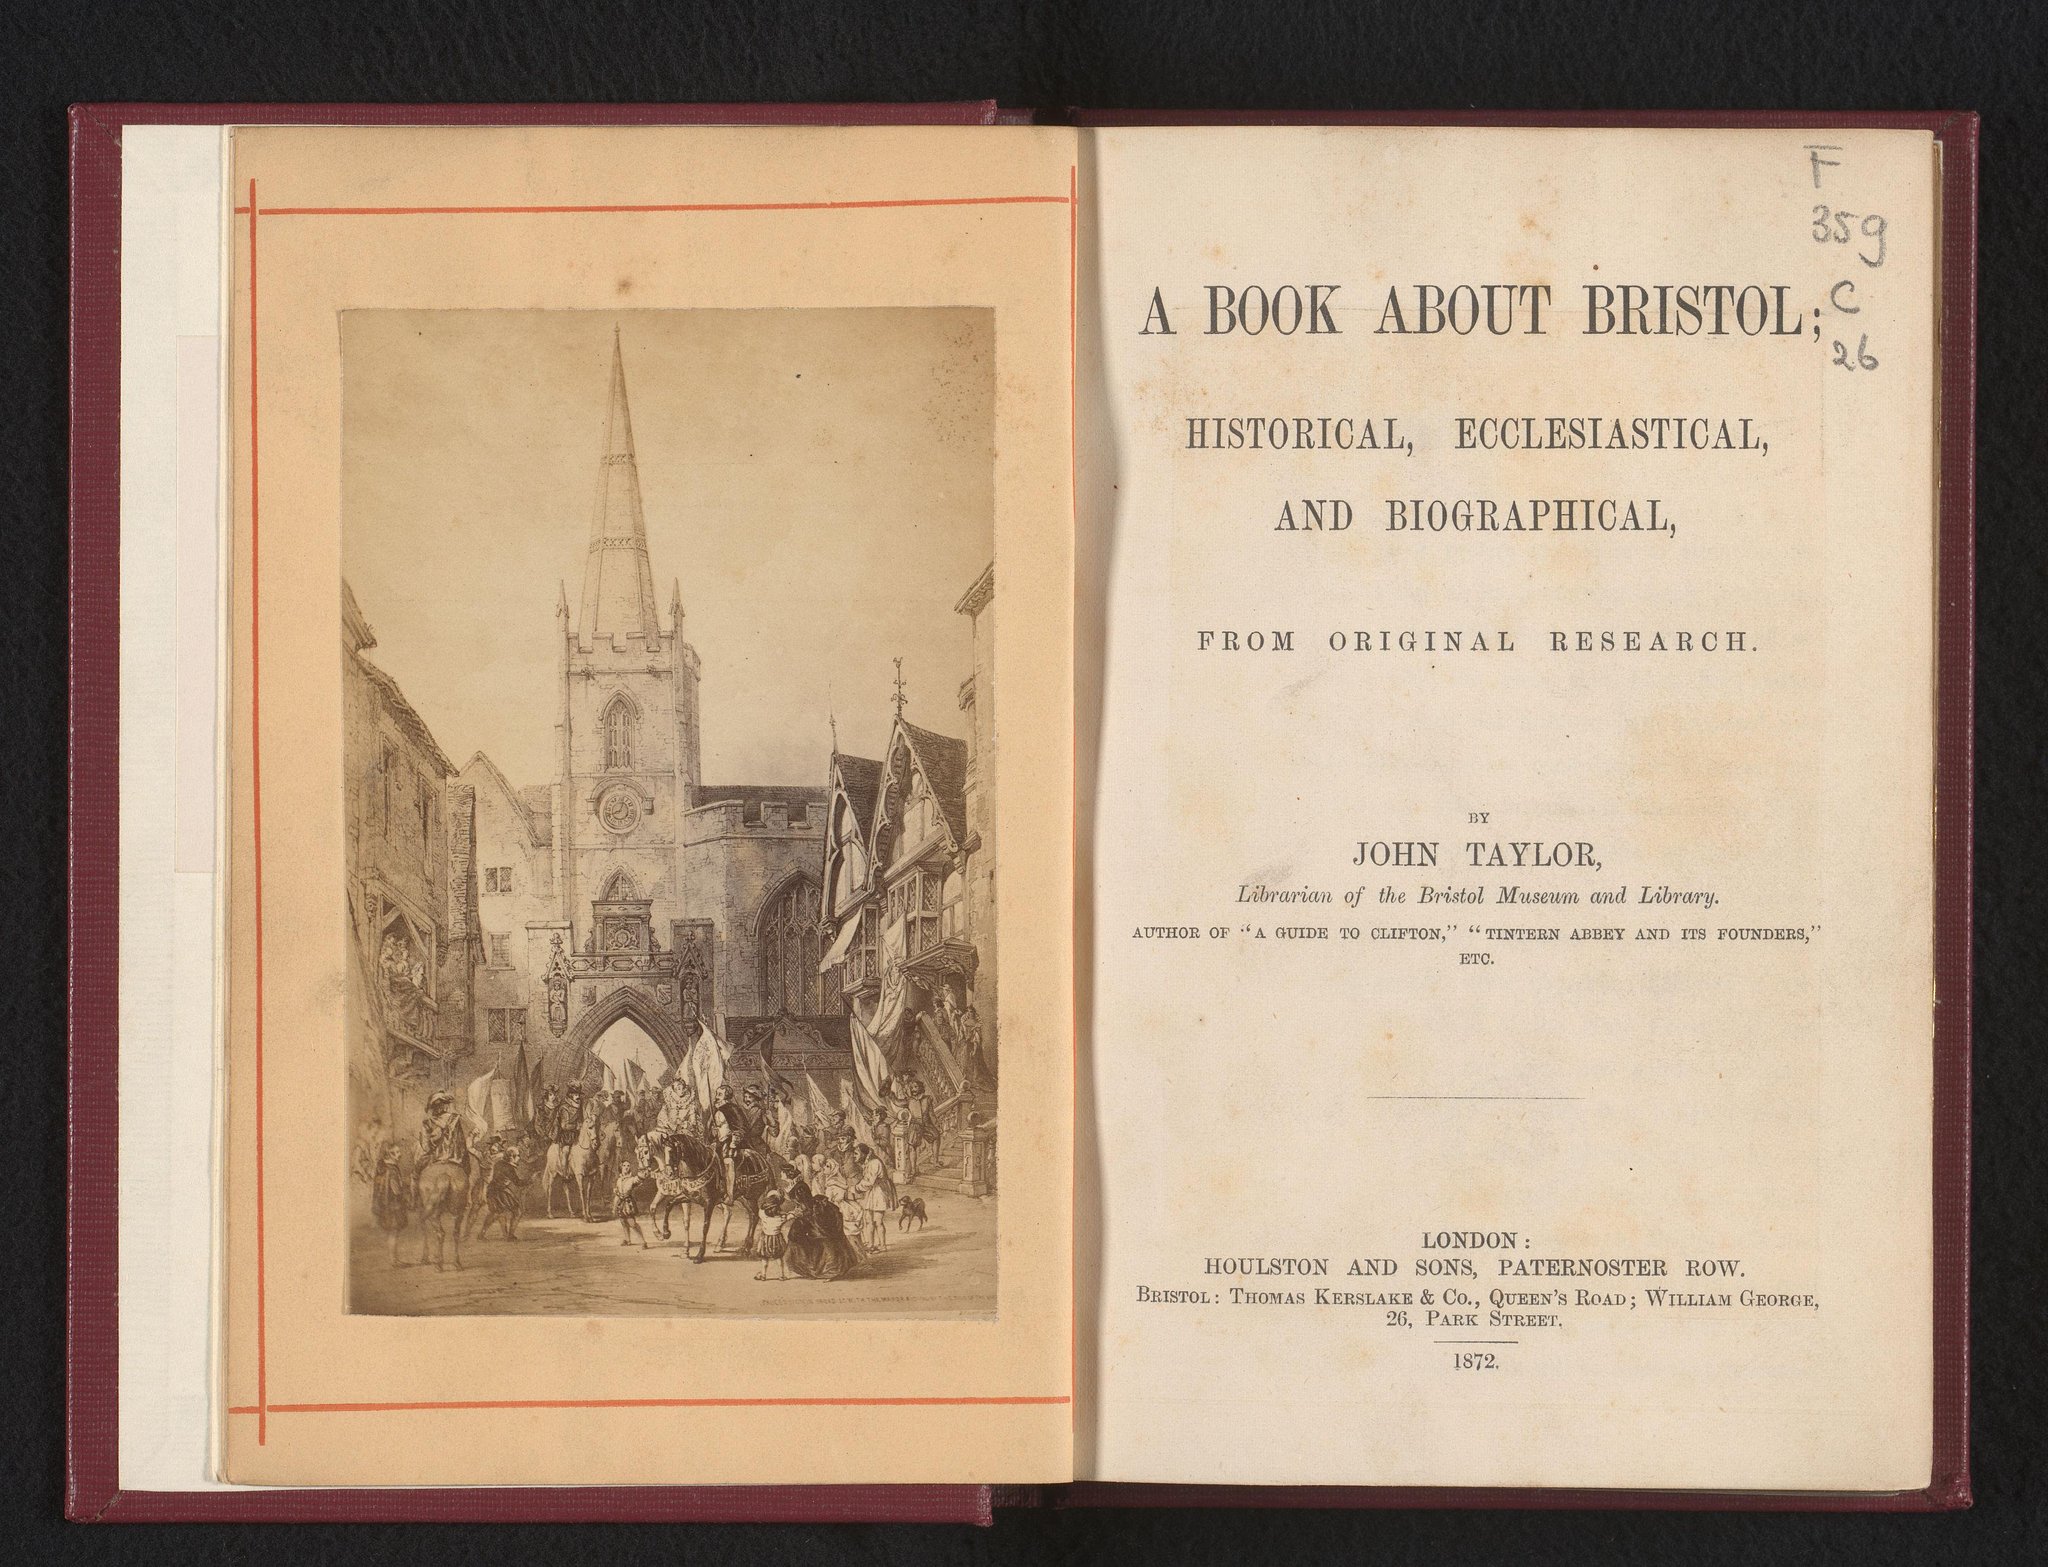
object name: book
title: A book about Bristol : historical, ecclesiastical, and biographical, from original research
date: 1872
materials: cardboard, paper, photographic support, textile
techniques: albumen print, printing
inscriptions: annotation: ‘JULY/ 1995’, annotation: ‘David [...] Wooding/ The birthday gift of his son Benjamin Dec 1876.’, annotation: ‘£ 50/ (-10% discount)/ orginal photographs/ 23 plates albumen 20 fron nature 3 from engravings’, collector's mark: ‘County of South Glamorgan/ Sir DeMorgannwg/ Central Reference/ Library’, collector's mark: ‘withdrawn from stock’